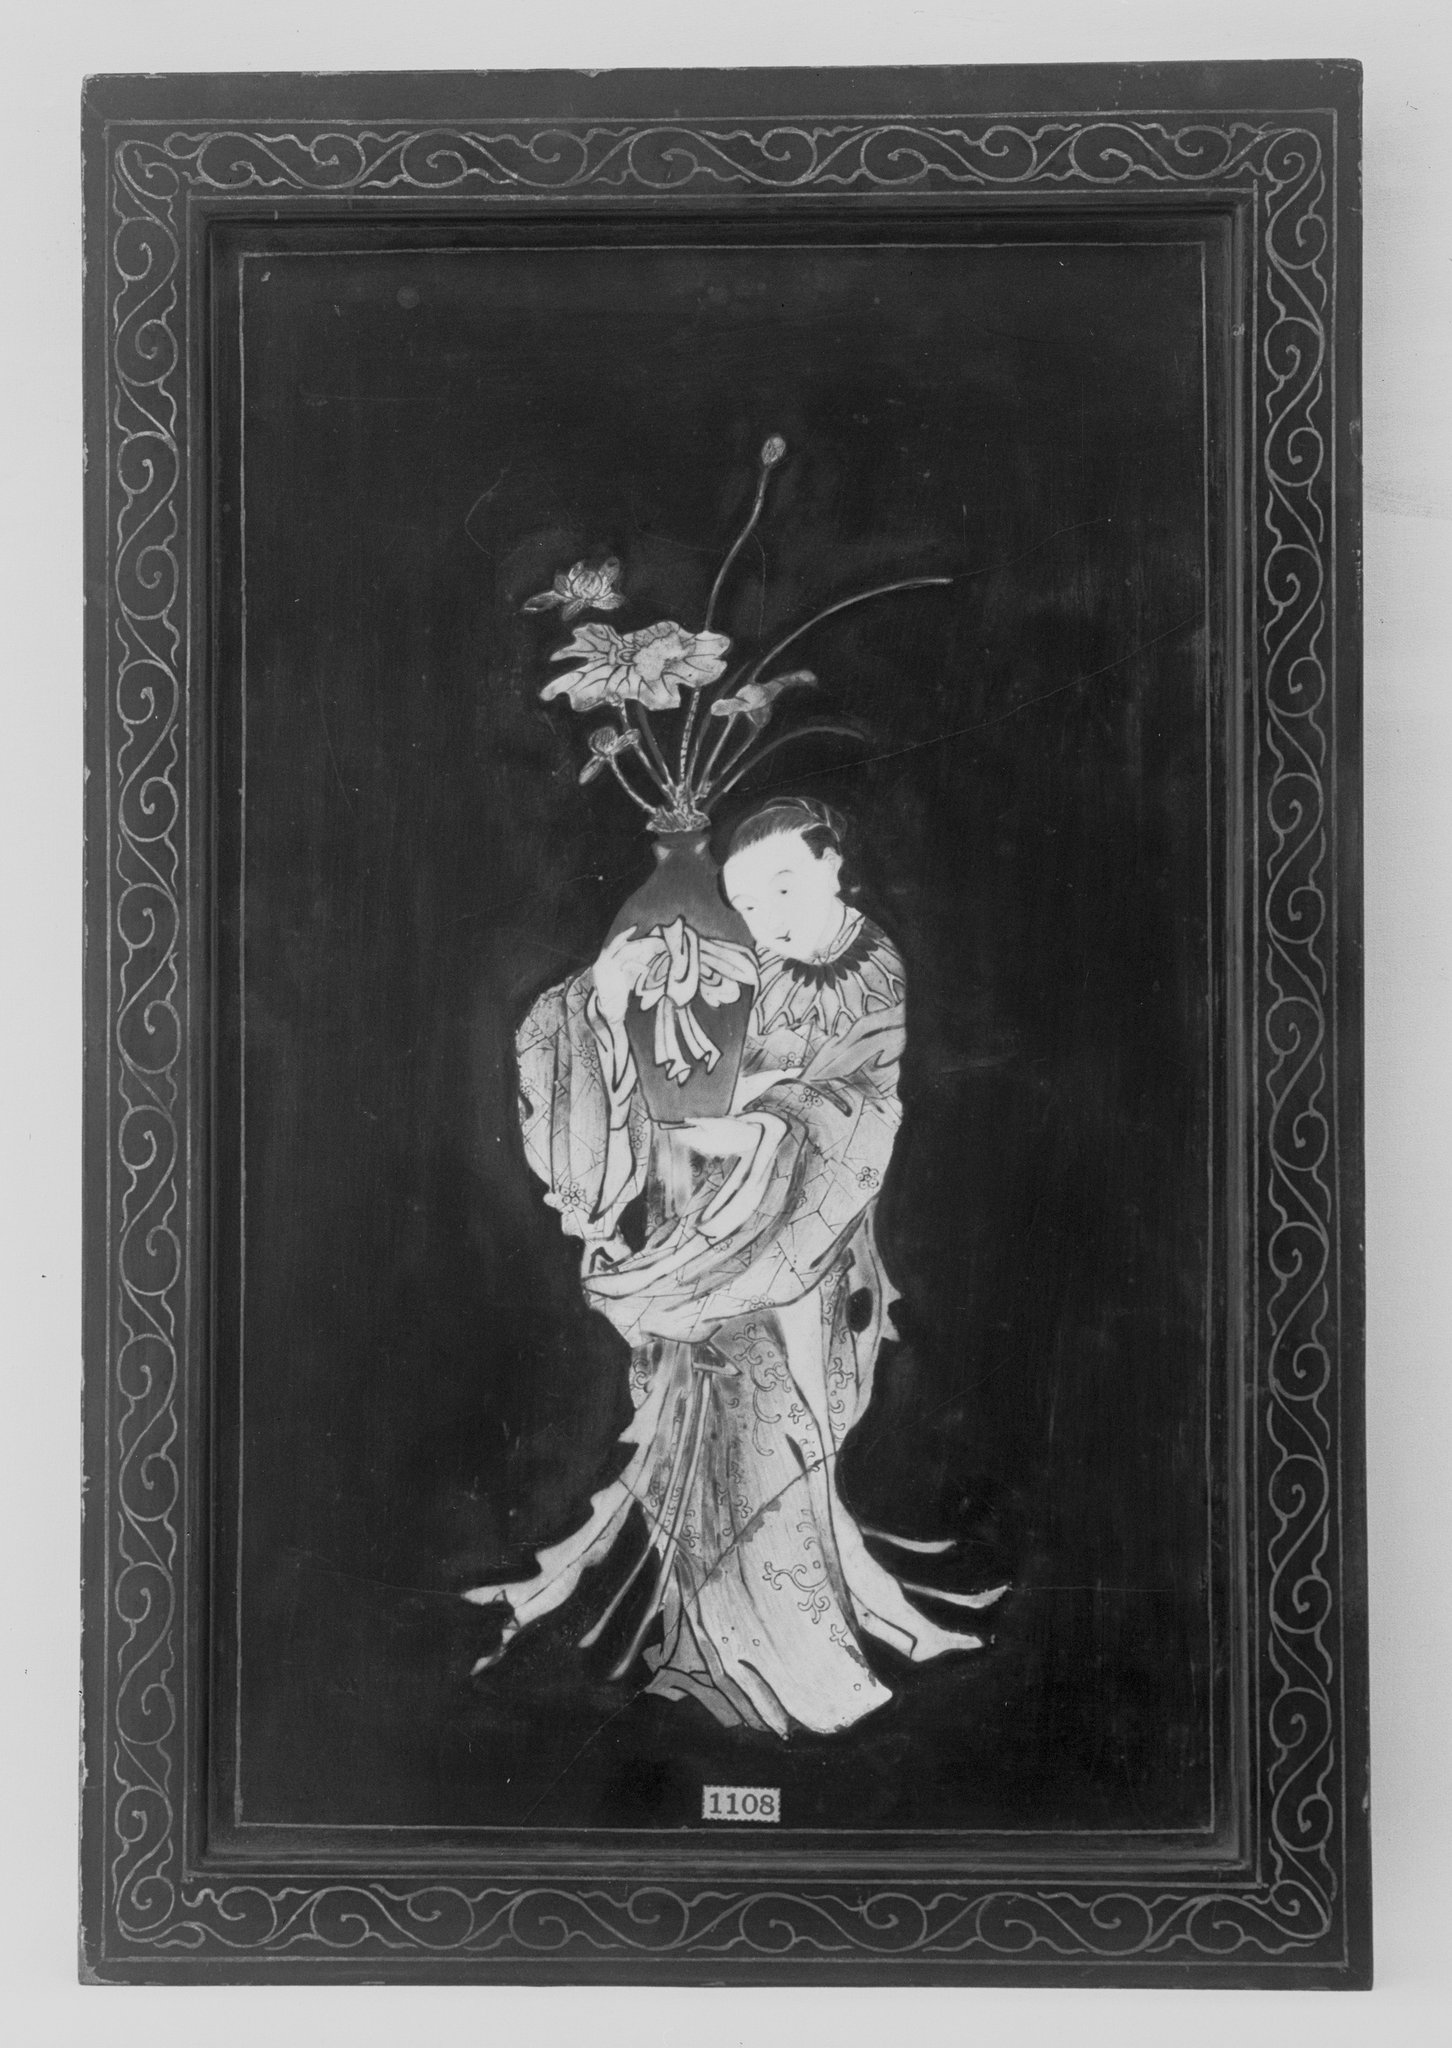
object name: plaque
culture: chinese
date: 1801-1850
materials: enamel, lacquer, porcelain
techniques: overglaze, painting, polychrome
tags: women,flowers